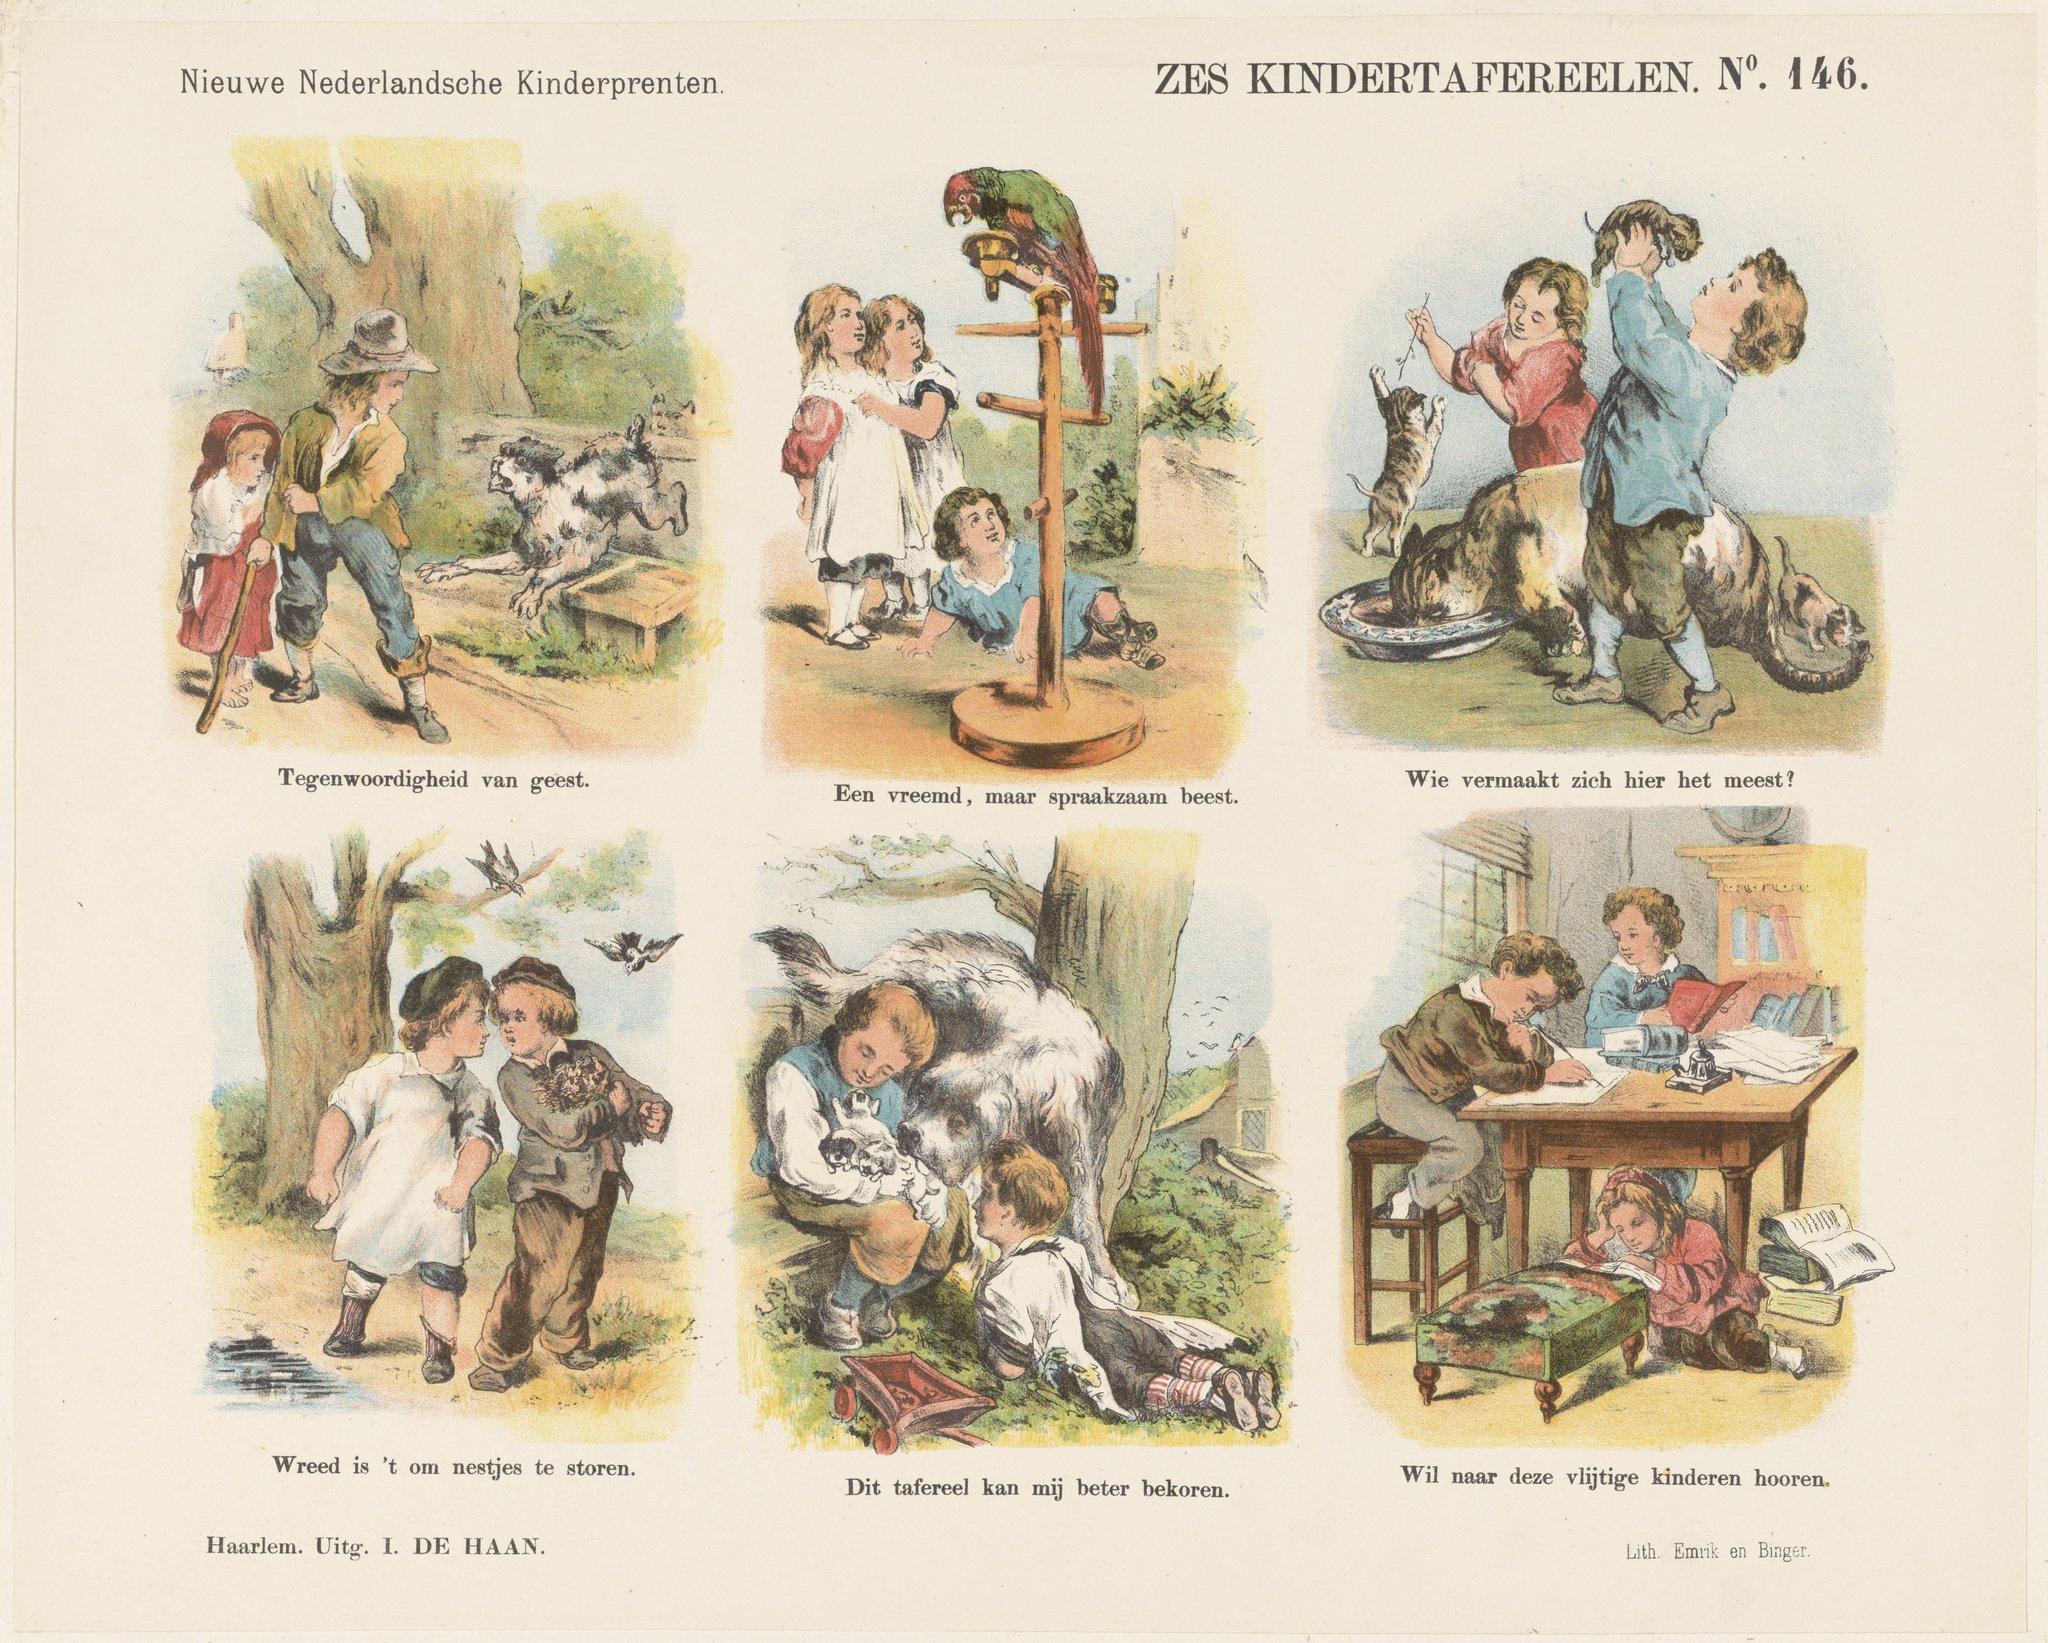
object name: print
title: Nieuwe Nederlandsche kinderprenten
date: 1875-1903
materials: paper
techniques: lithograph, letterpress printing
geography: haarlem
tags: child, child playing with animals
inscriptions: collector's mark: Lugt 2760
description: Blad met 6 voorstellingen van kindertaferelen, waaronder kinderen die spelen met dieren en kinderen die huiswerk maken. Onder elke afbeelding een onderschrift. Genummerd rechtsboven: No. 146.